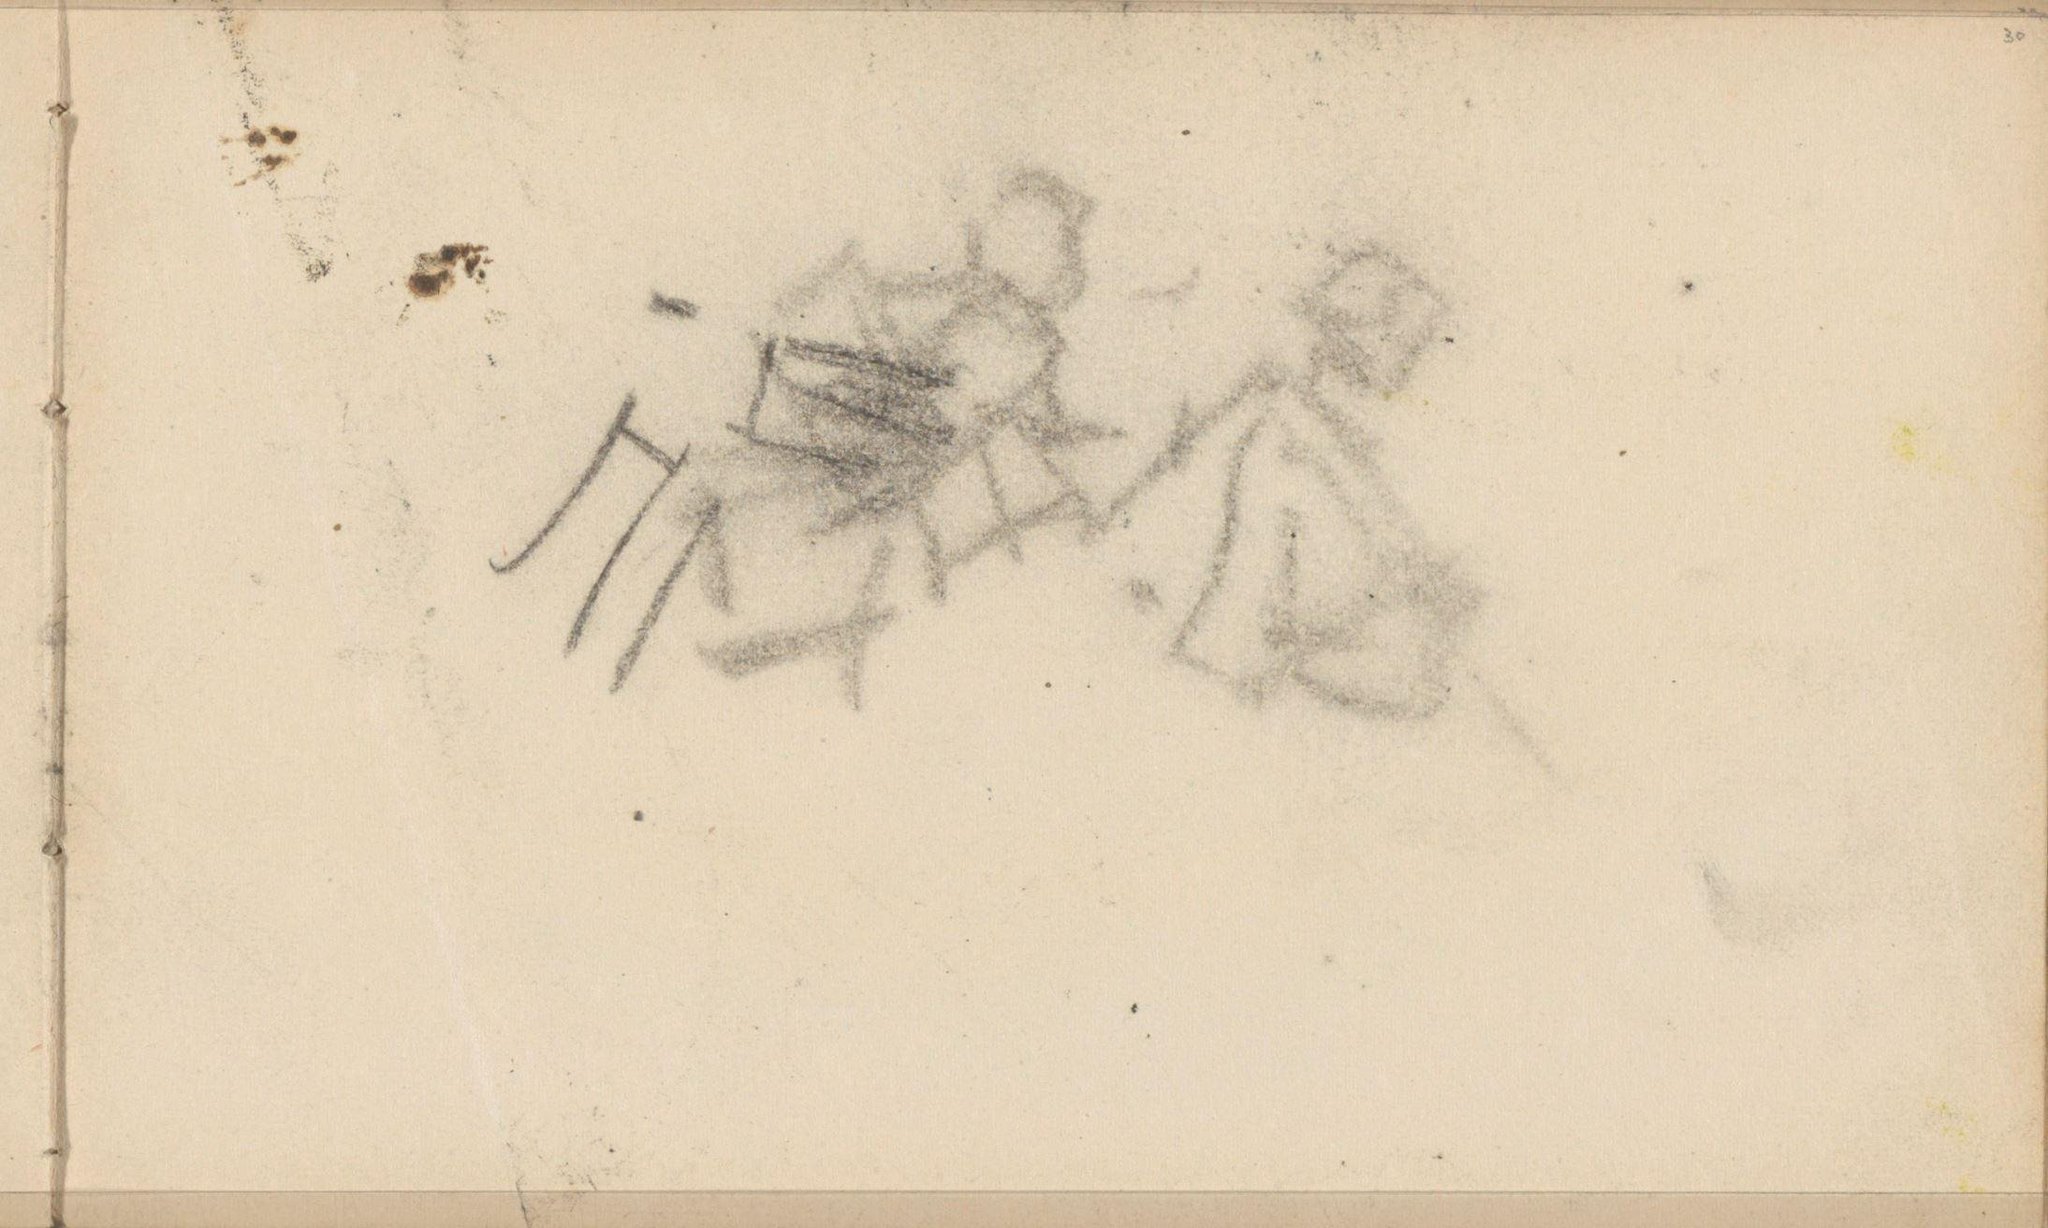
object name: sketchbook leaf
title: Studie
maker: george hendrik breitner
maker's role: draughtsman, painter, print maker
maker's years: 1857-1923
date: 1884-1886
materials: chalk, paper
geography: the hague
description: Pagina 30 uit een schetsboek met 35 bladen.